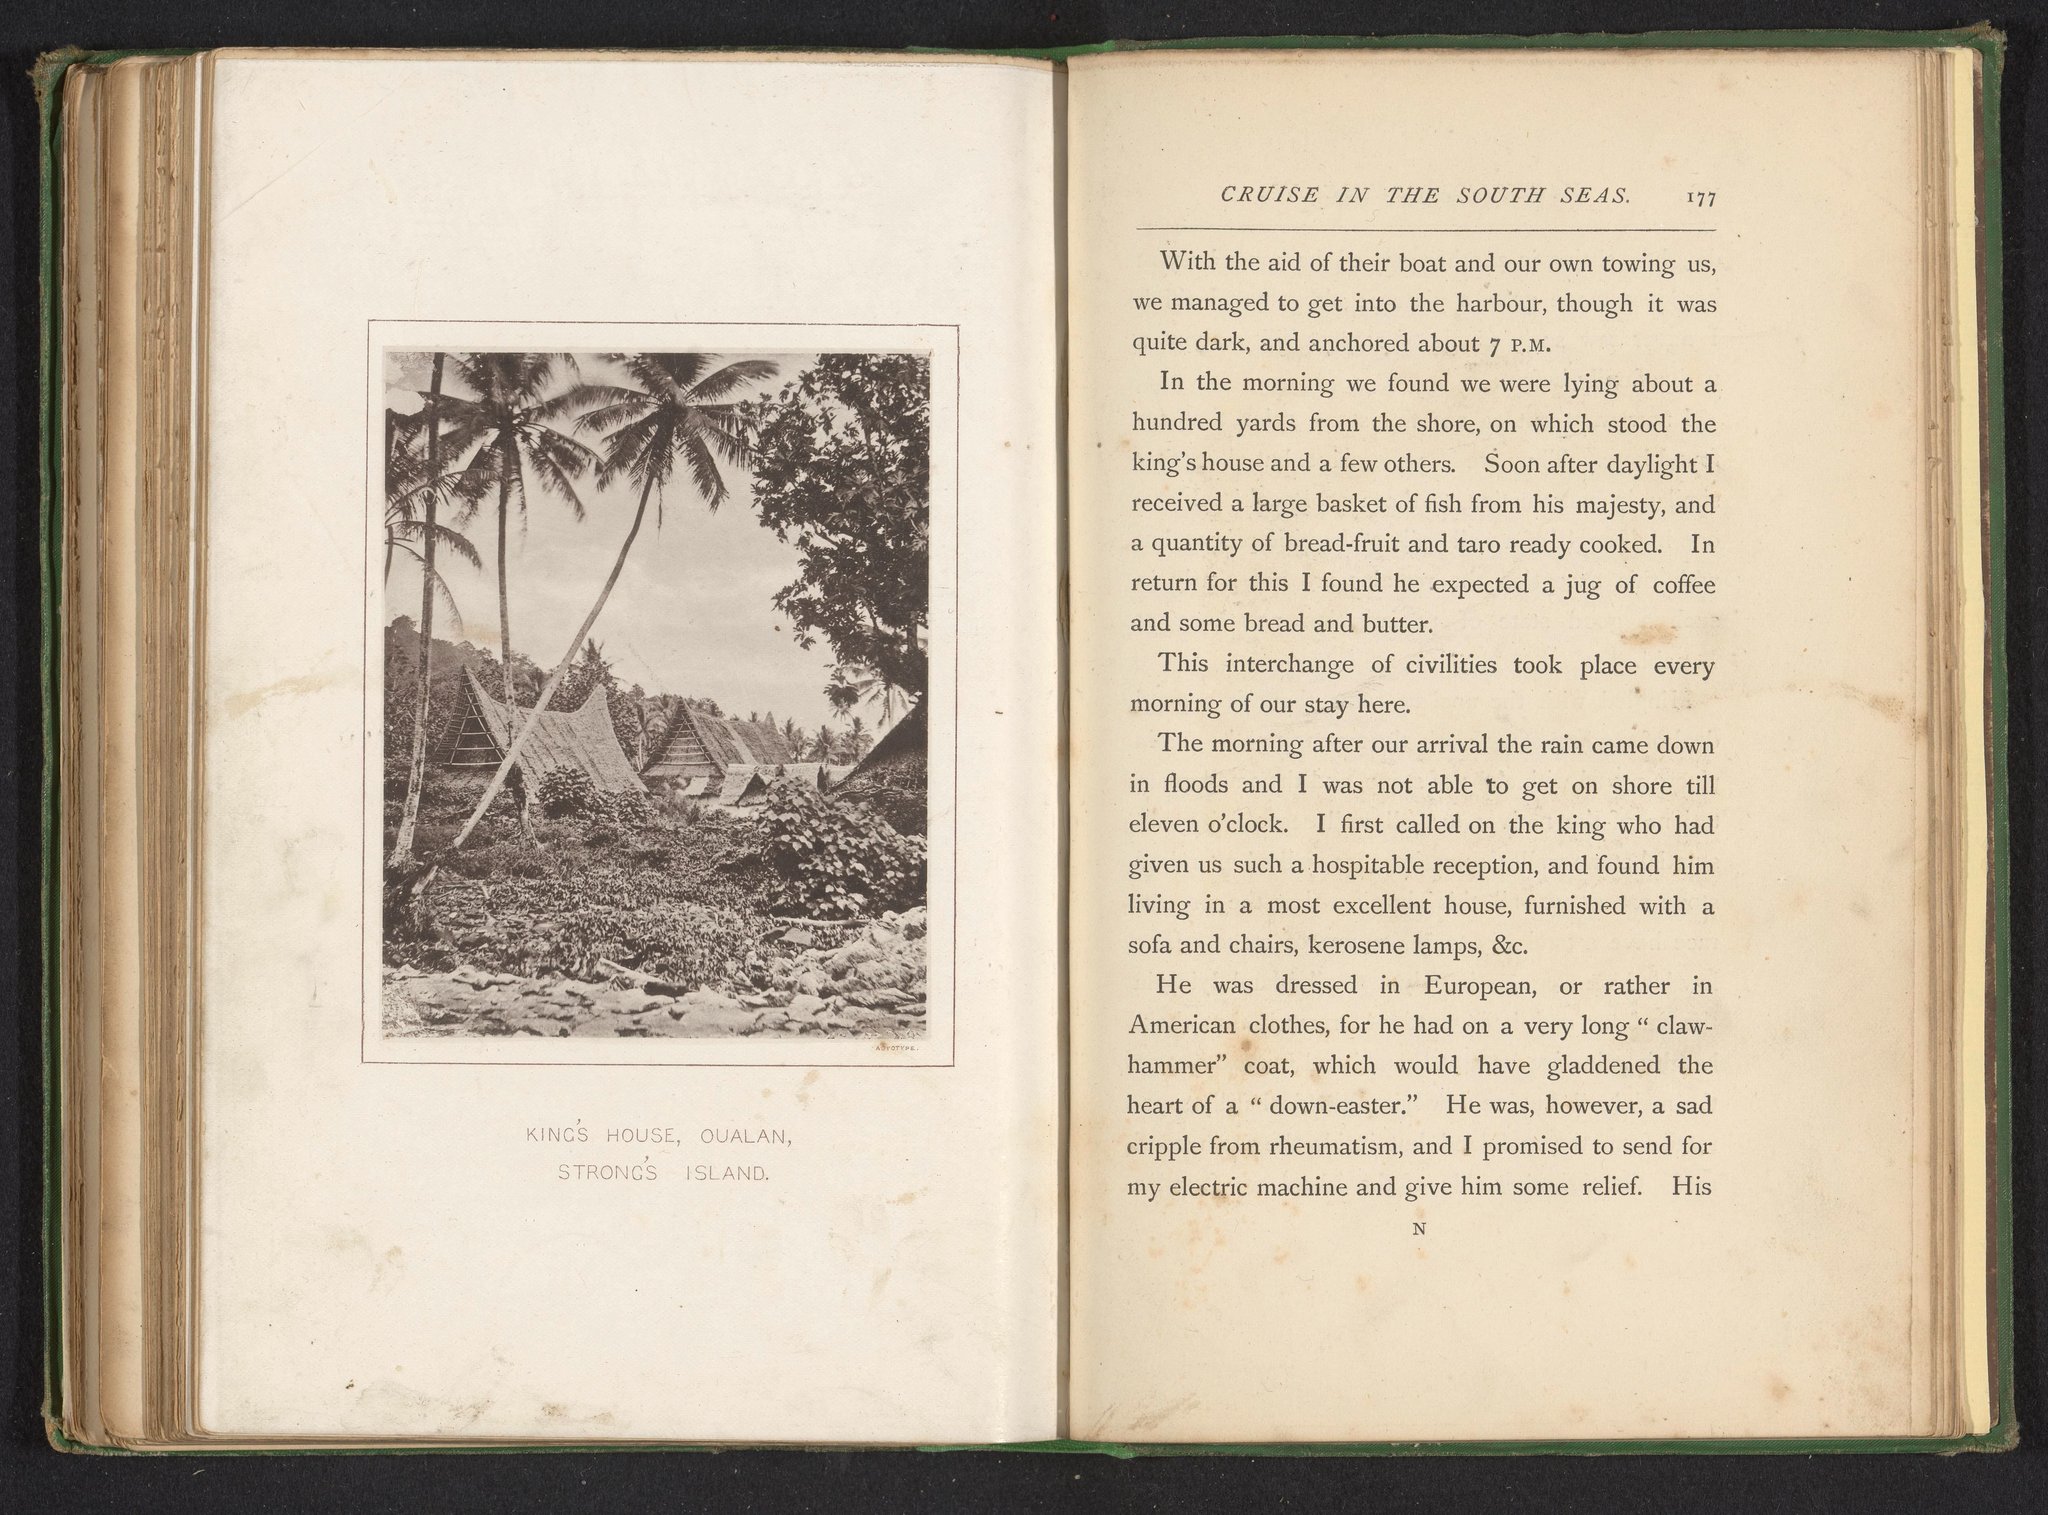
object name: page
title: Huis van een koning op een eiland in Oceanië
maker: george smith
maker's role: fotograaf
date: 1865-1875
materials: paper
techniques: photograph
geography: oceania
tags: housing, trees: palm-tree